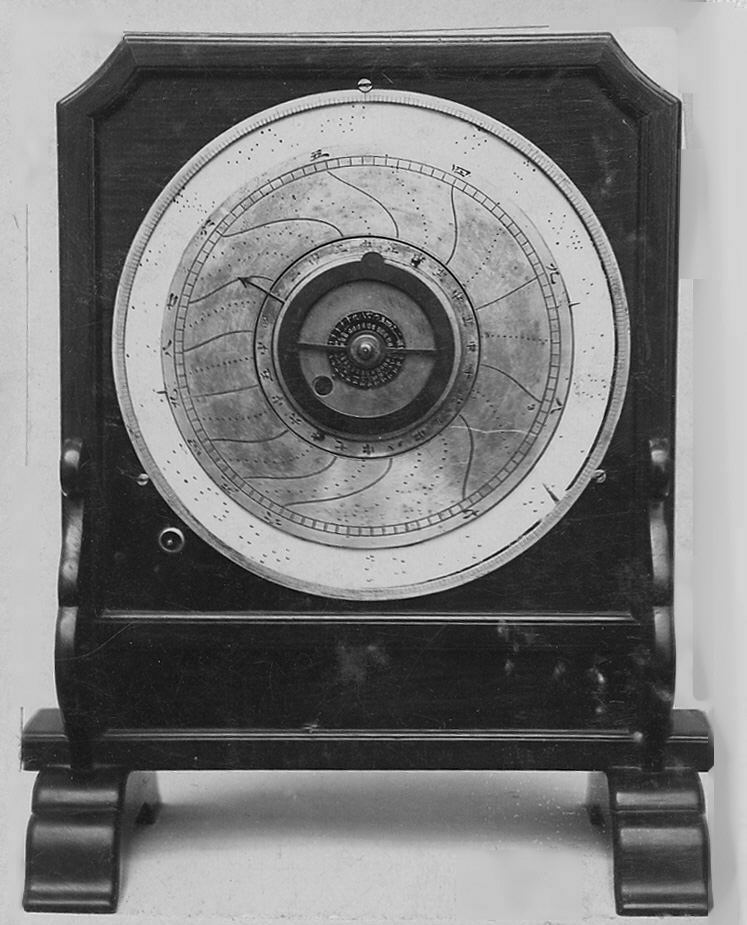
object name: clock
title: Astronomical Clock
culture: japanese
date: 1701-1900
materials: brass, steel, wood